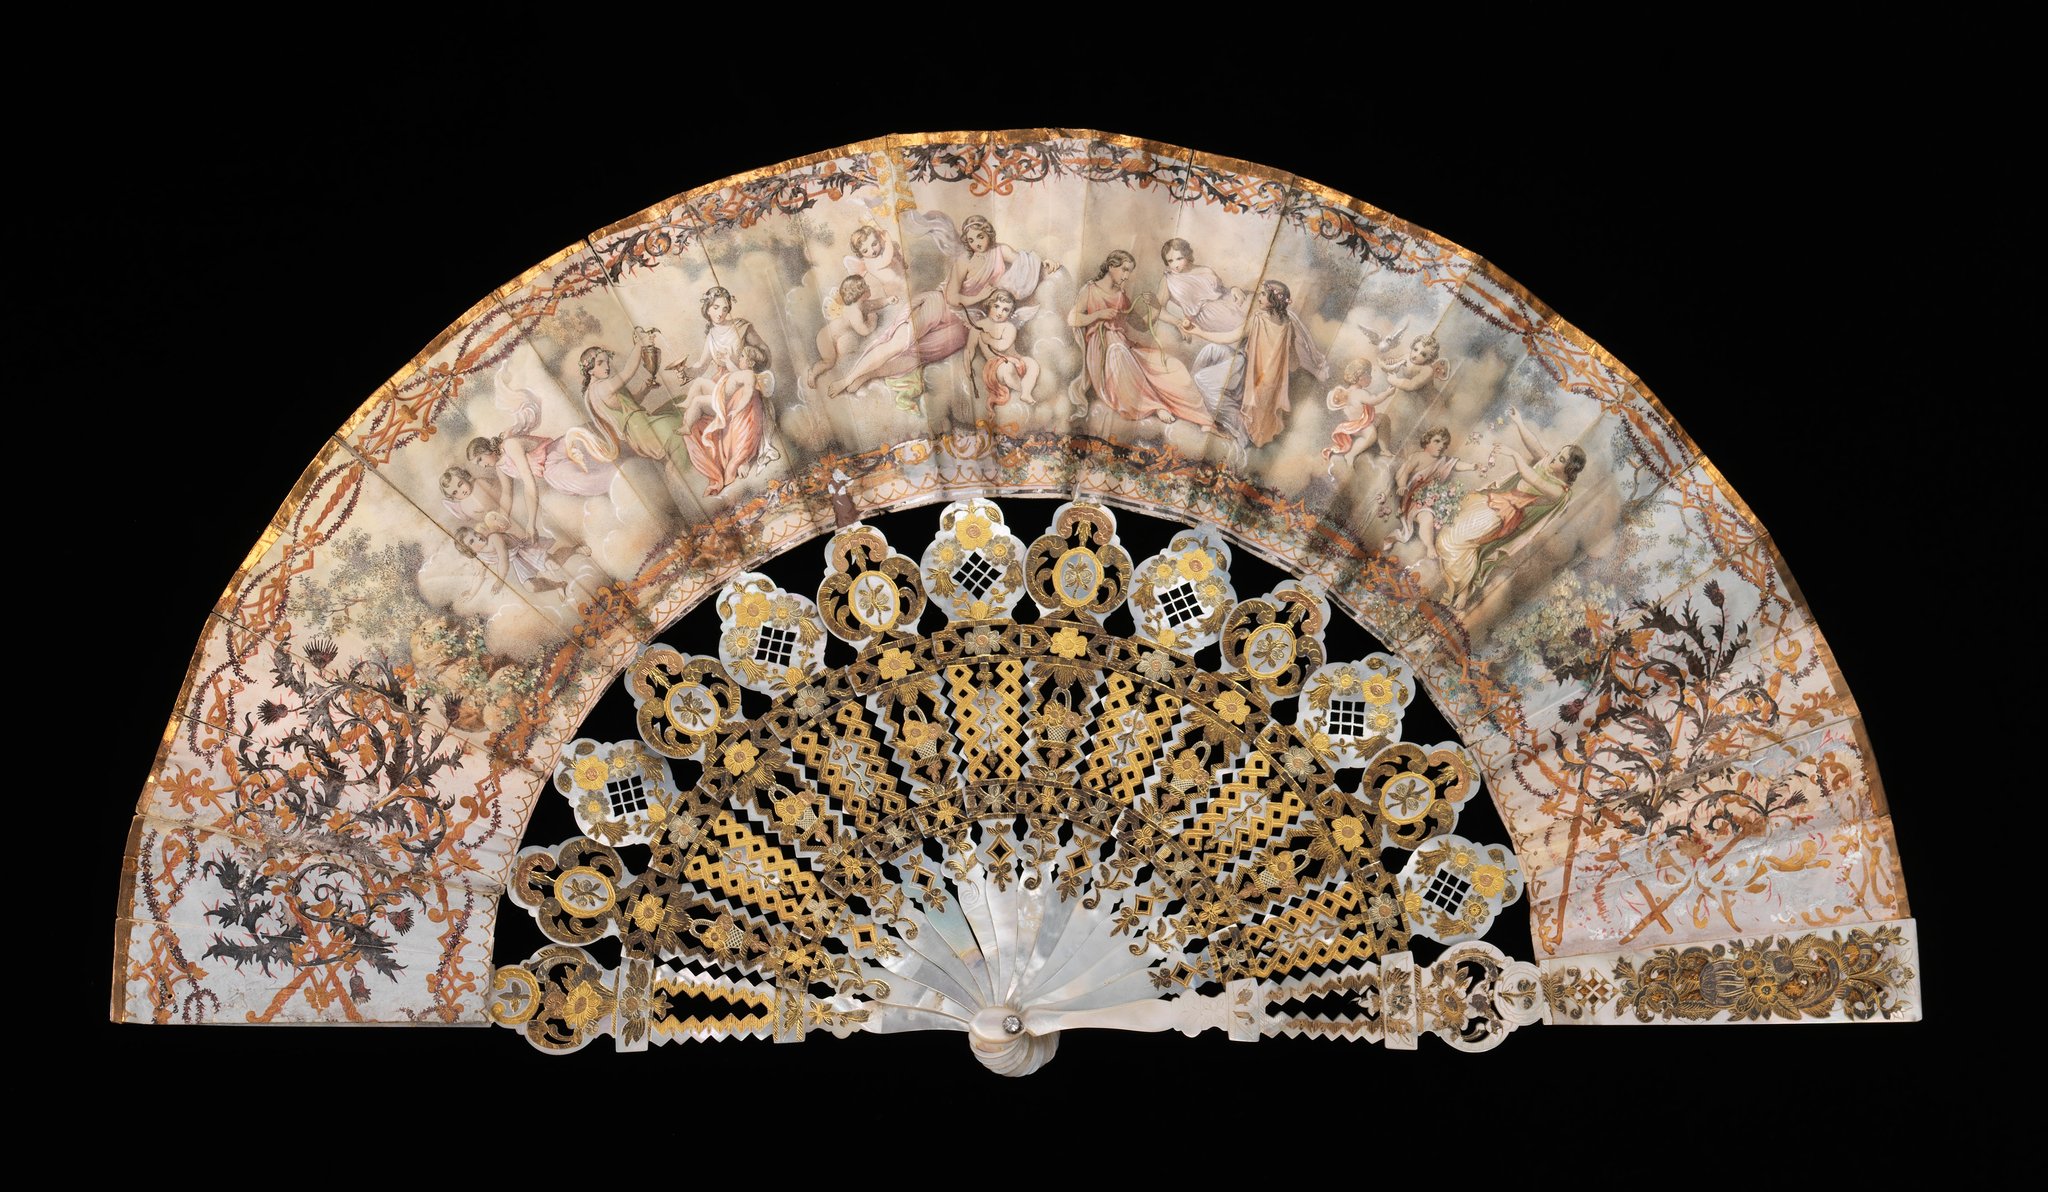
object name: fan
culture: european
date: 1855-1865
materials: metal, mother of pearl, paper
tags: men,women,putti